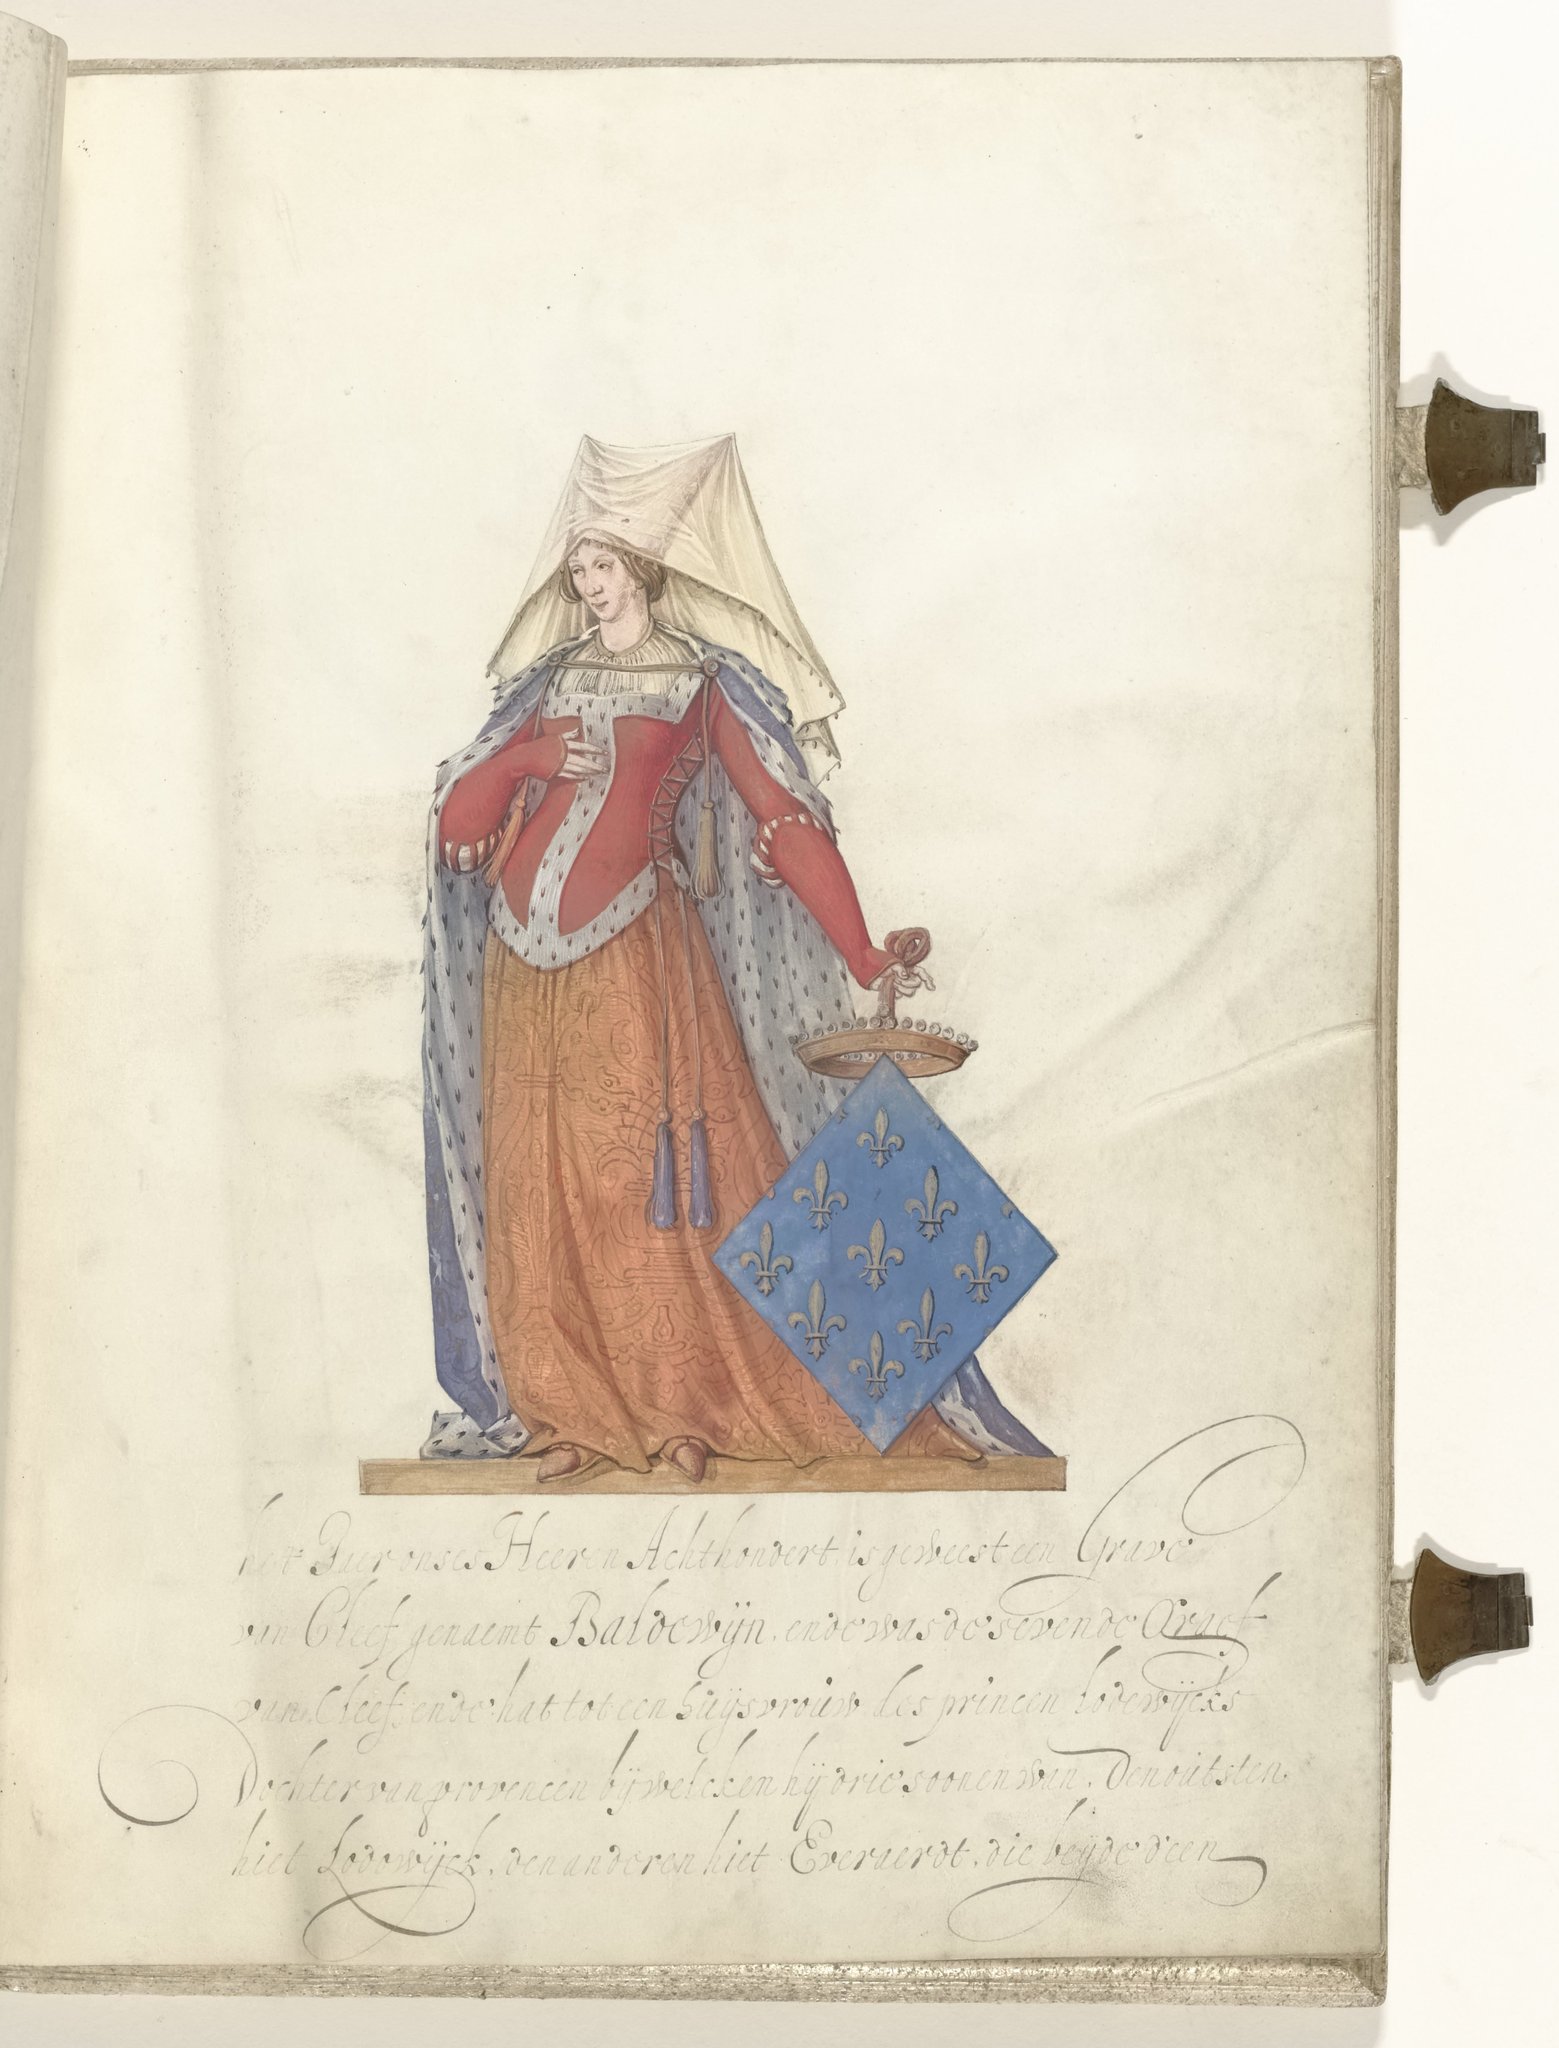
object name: drawing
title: Hildegarde der Franken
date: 1590-1593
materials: paint, gouache, ink, parchment, watercolor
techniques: writing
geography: northern netherlands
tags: culemborg, heren en graven van, hildegarde der franken gravin van kleef, graven van teisterbant, culemborg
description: Hildegarde der Franken, gravin van Kleef, echtgenote van Boudewijn van Kleef en Teisterbant. Staande ten voeten uit het het wapen van Frankrijk. Onderdeel van geïllustreerd handschrift met de genealogie van de heren en graven van Culemborg.